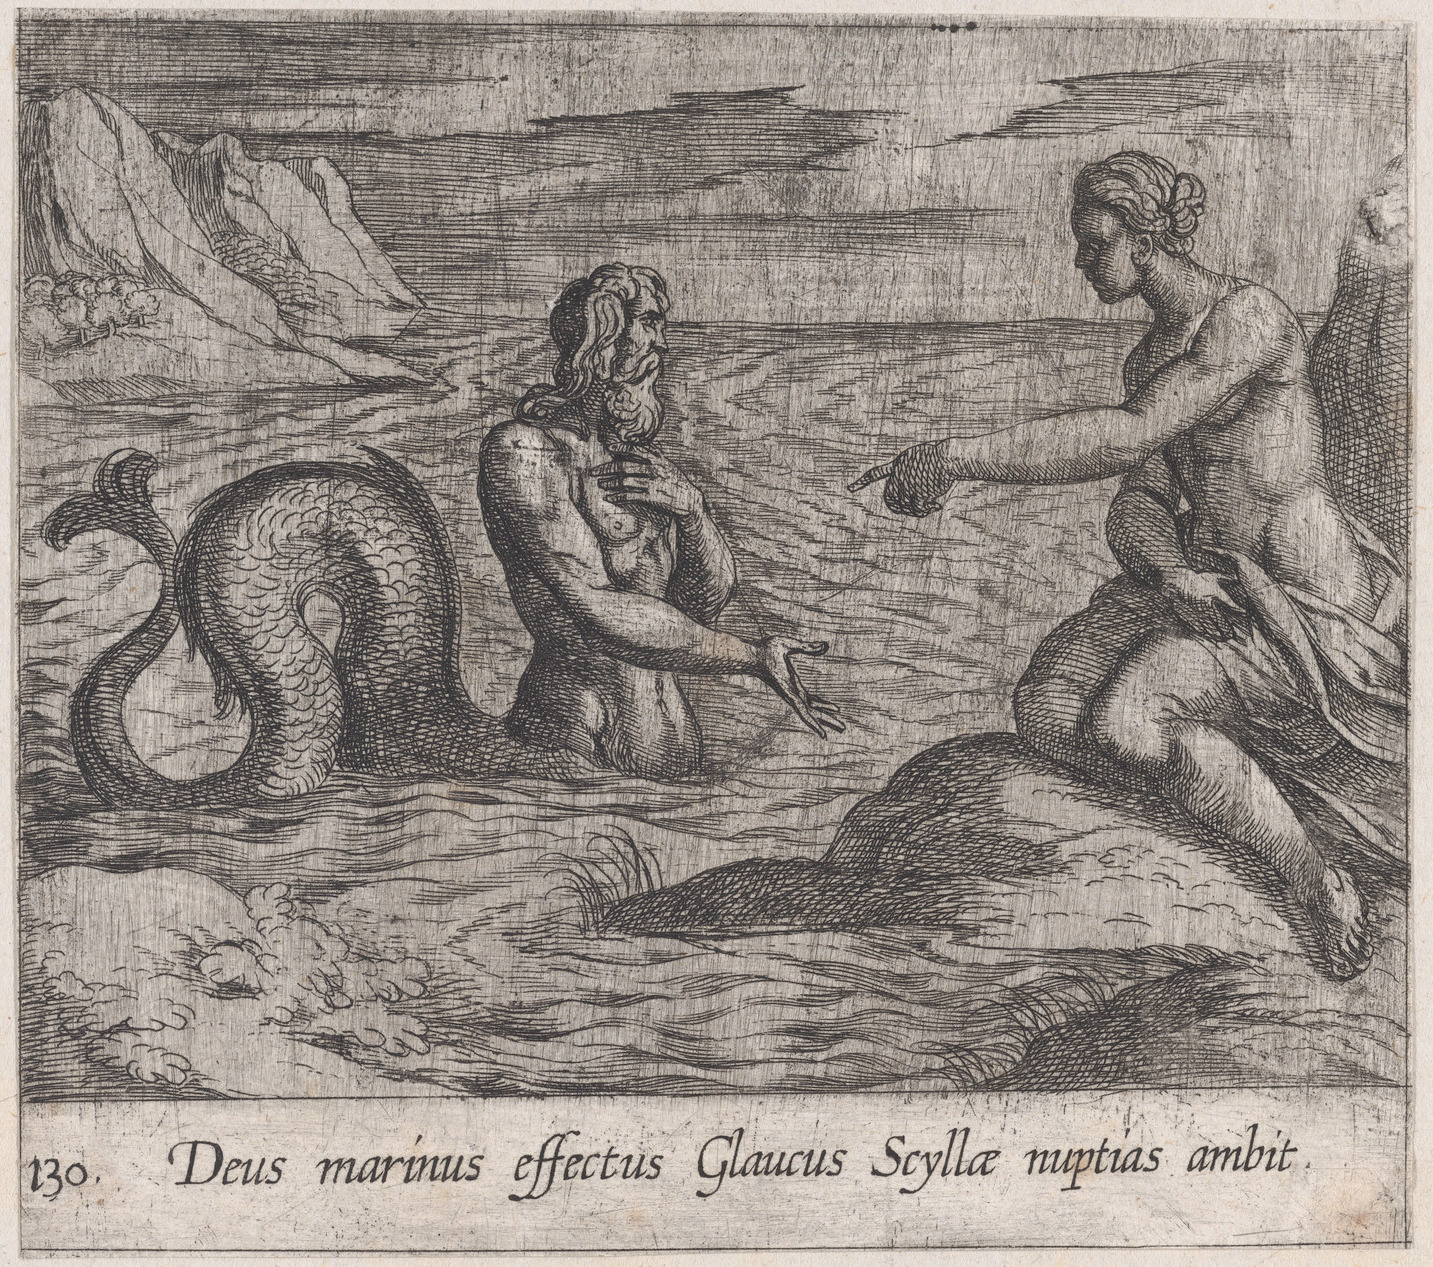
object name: print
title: Plate 130: Scylla and Glaucus (Deus marinus effectus Glaucus Scyllae nuptias ambit), from Ovid's 'Metamorphoses'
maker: antonio tempesta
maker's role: artist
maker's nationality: italian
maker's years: 1555-1630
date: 1606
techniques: etching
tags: female nudes,monsters